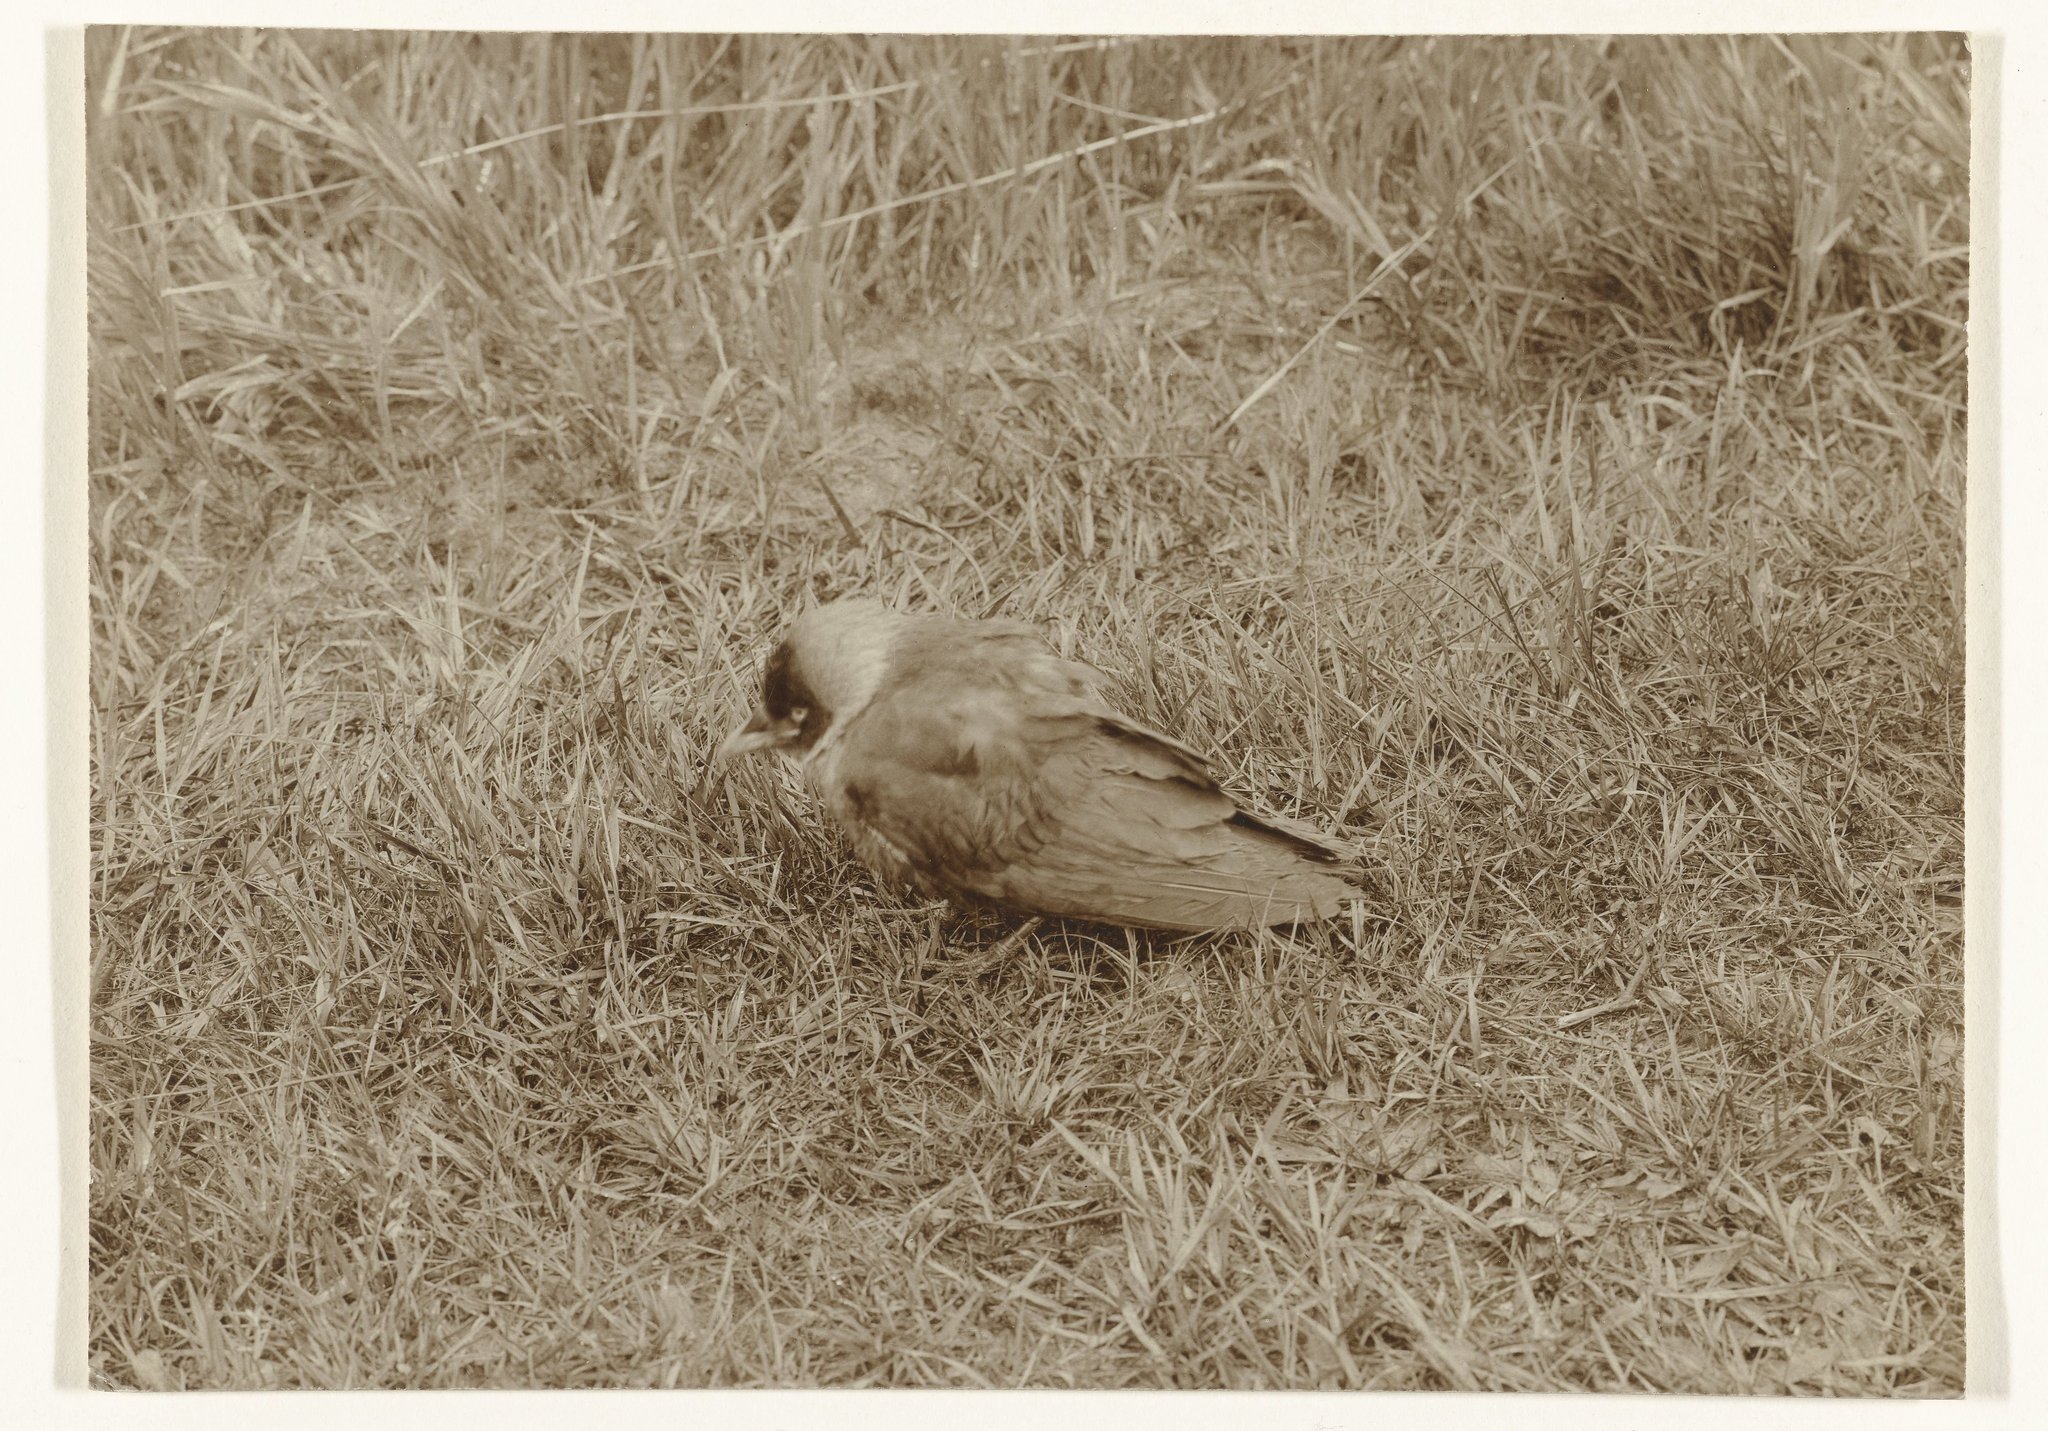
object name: photograph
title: Kauw in en weiland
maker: richard tepe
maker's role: fotograaf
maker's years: 1864-1952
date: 1900-1930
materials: paper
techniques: gelatin silver print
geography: netherlands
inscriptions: annotation: ‘Dohle in einer Wiese’, signature: ‘foto / R Tepe’